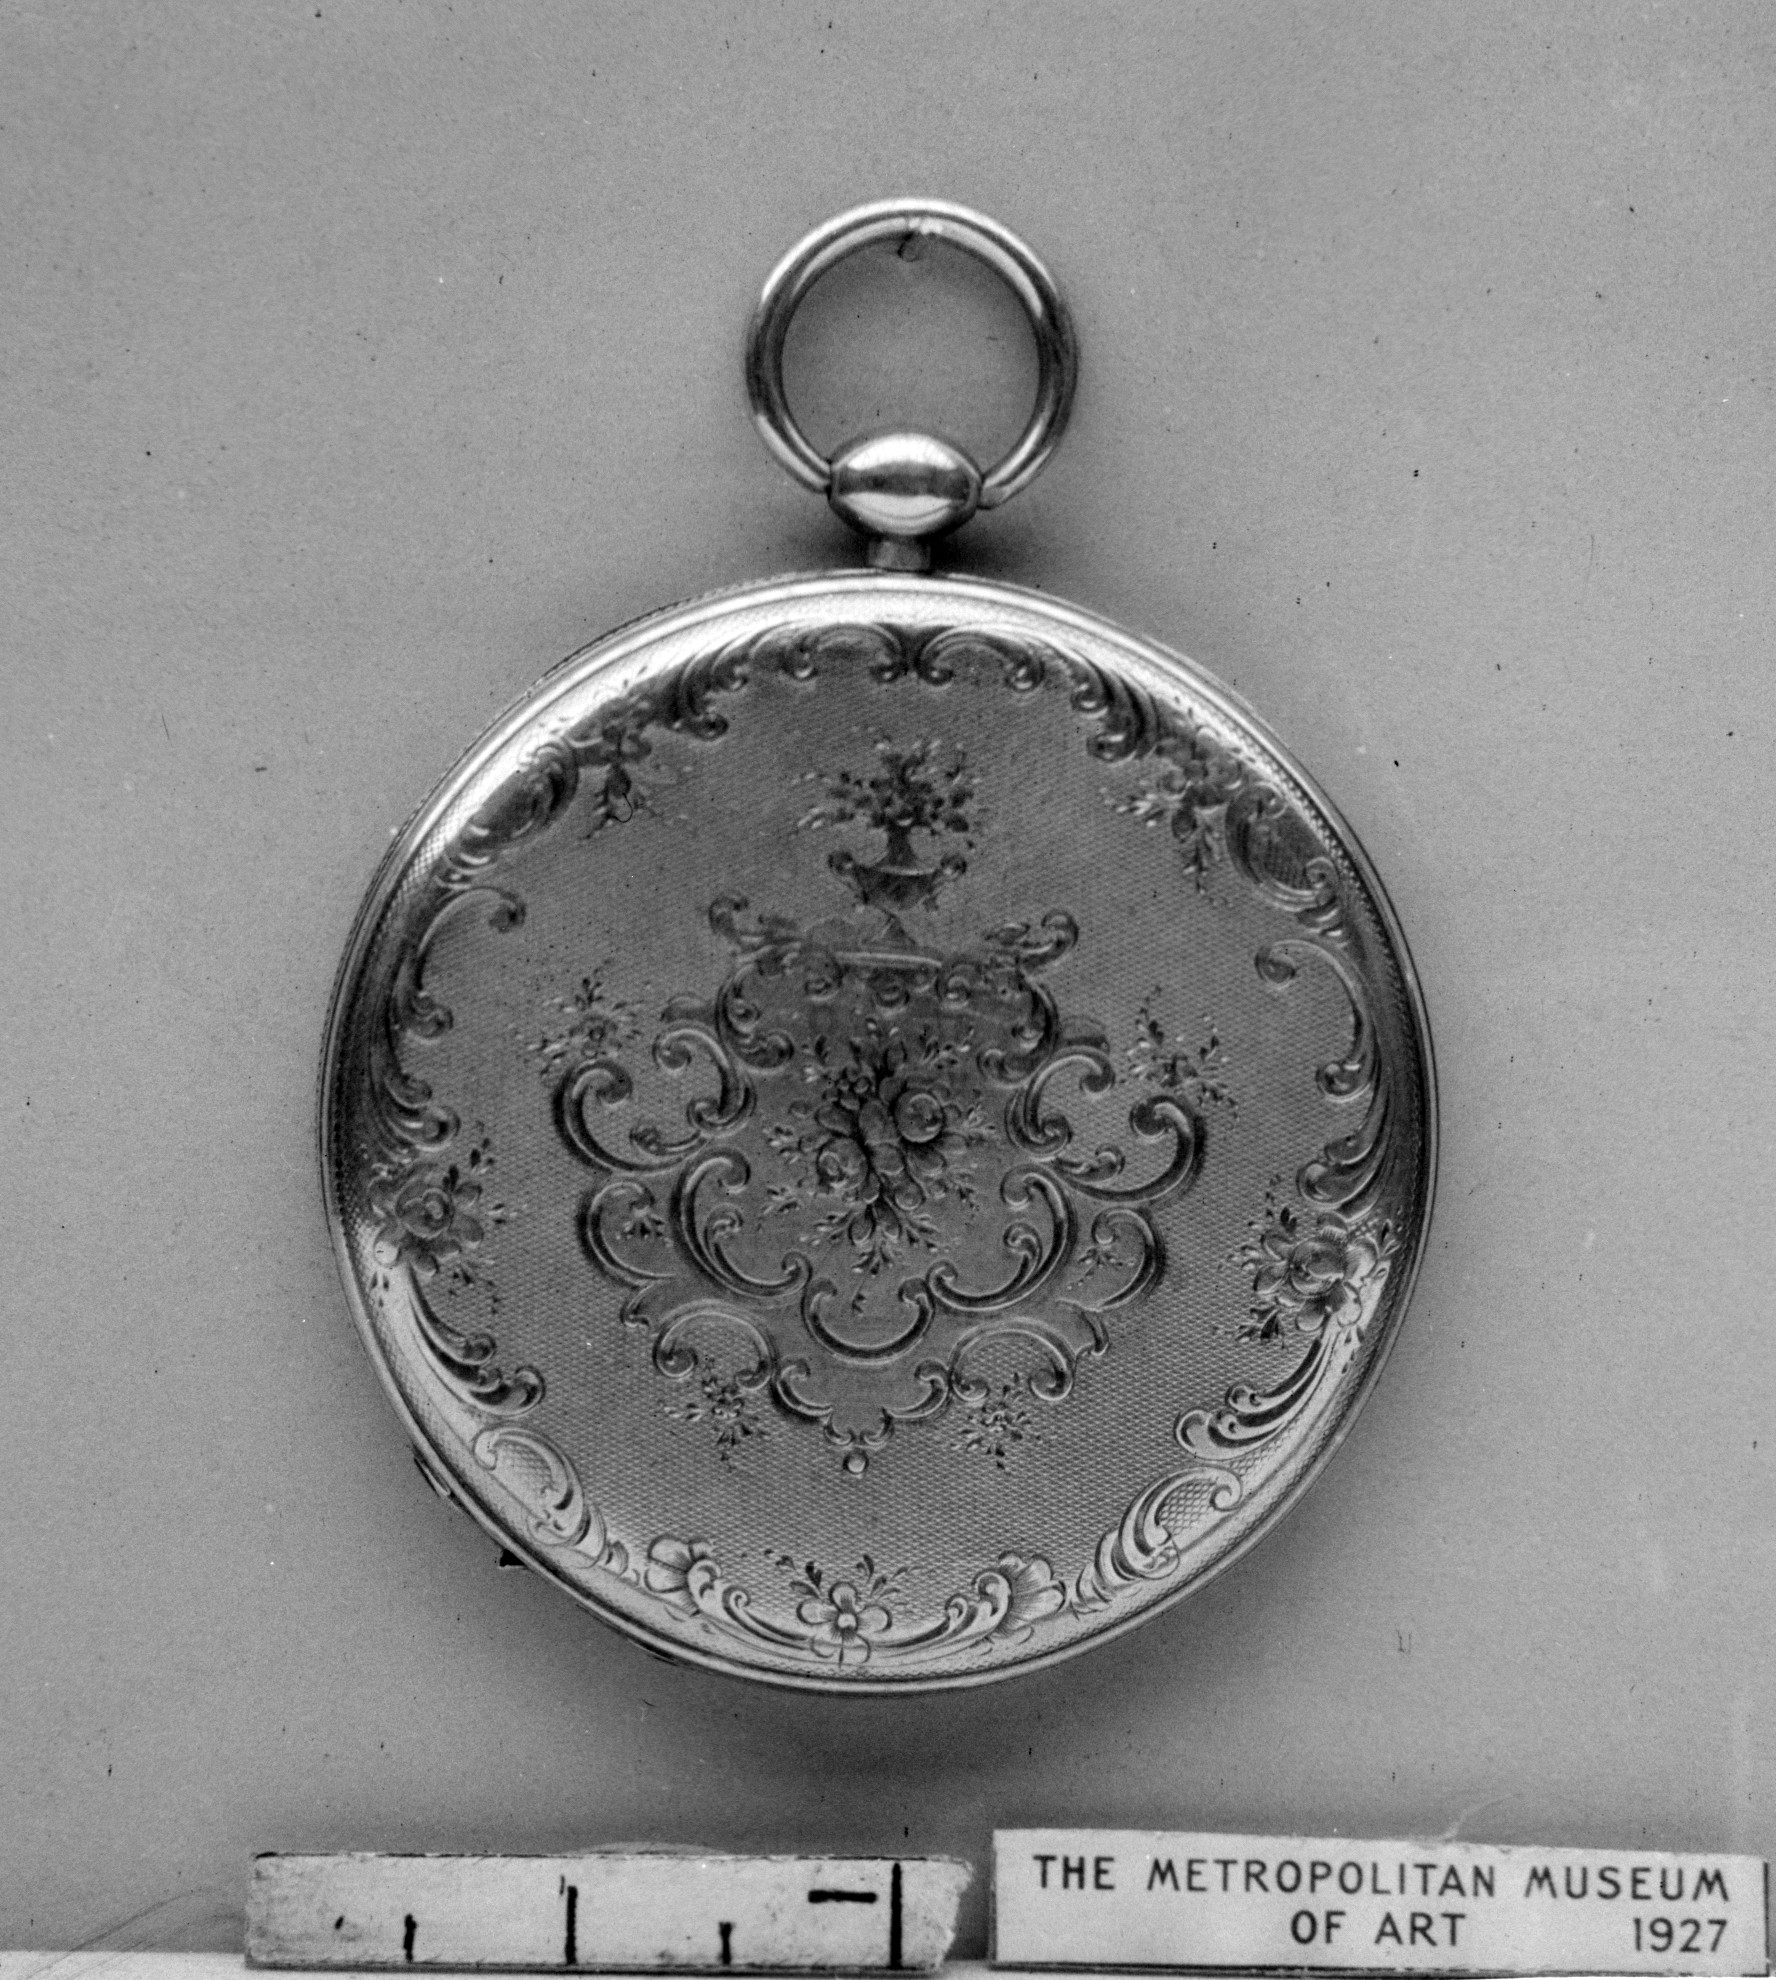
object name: watch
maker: mermod frères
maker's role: maker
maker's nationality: swiss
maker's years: 1875-1899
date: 1840-1855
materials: enamel, gold